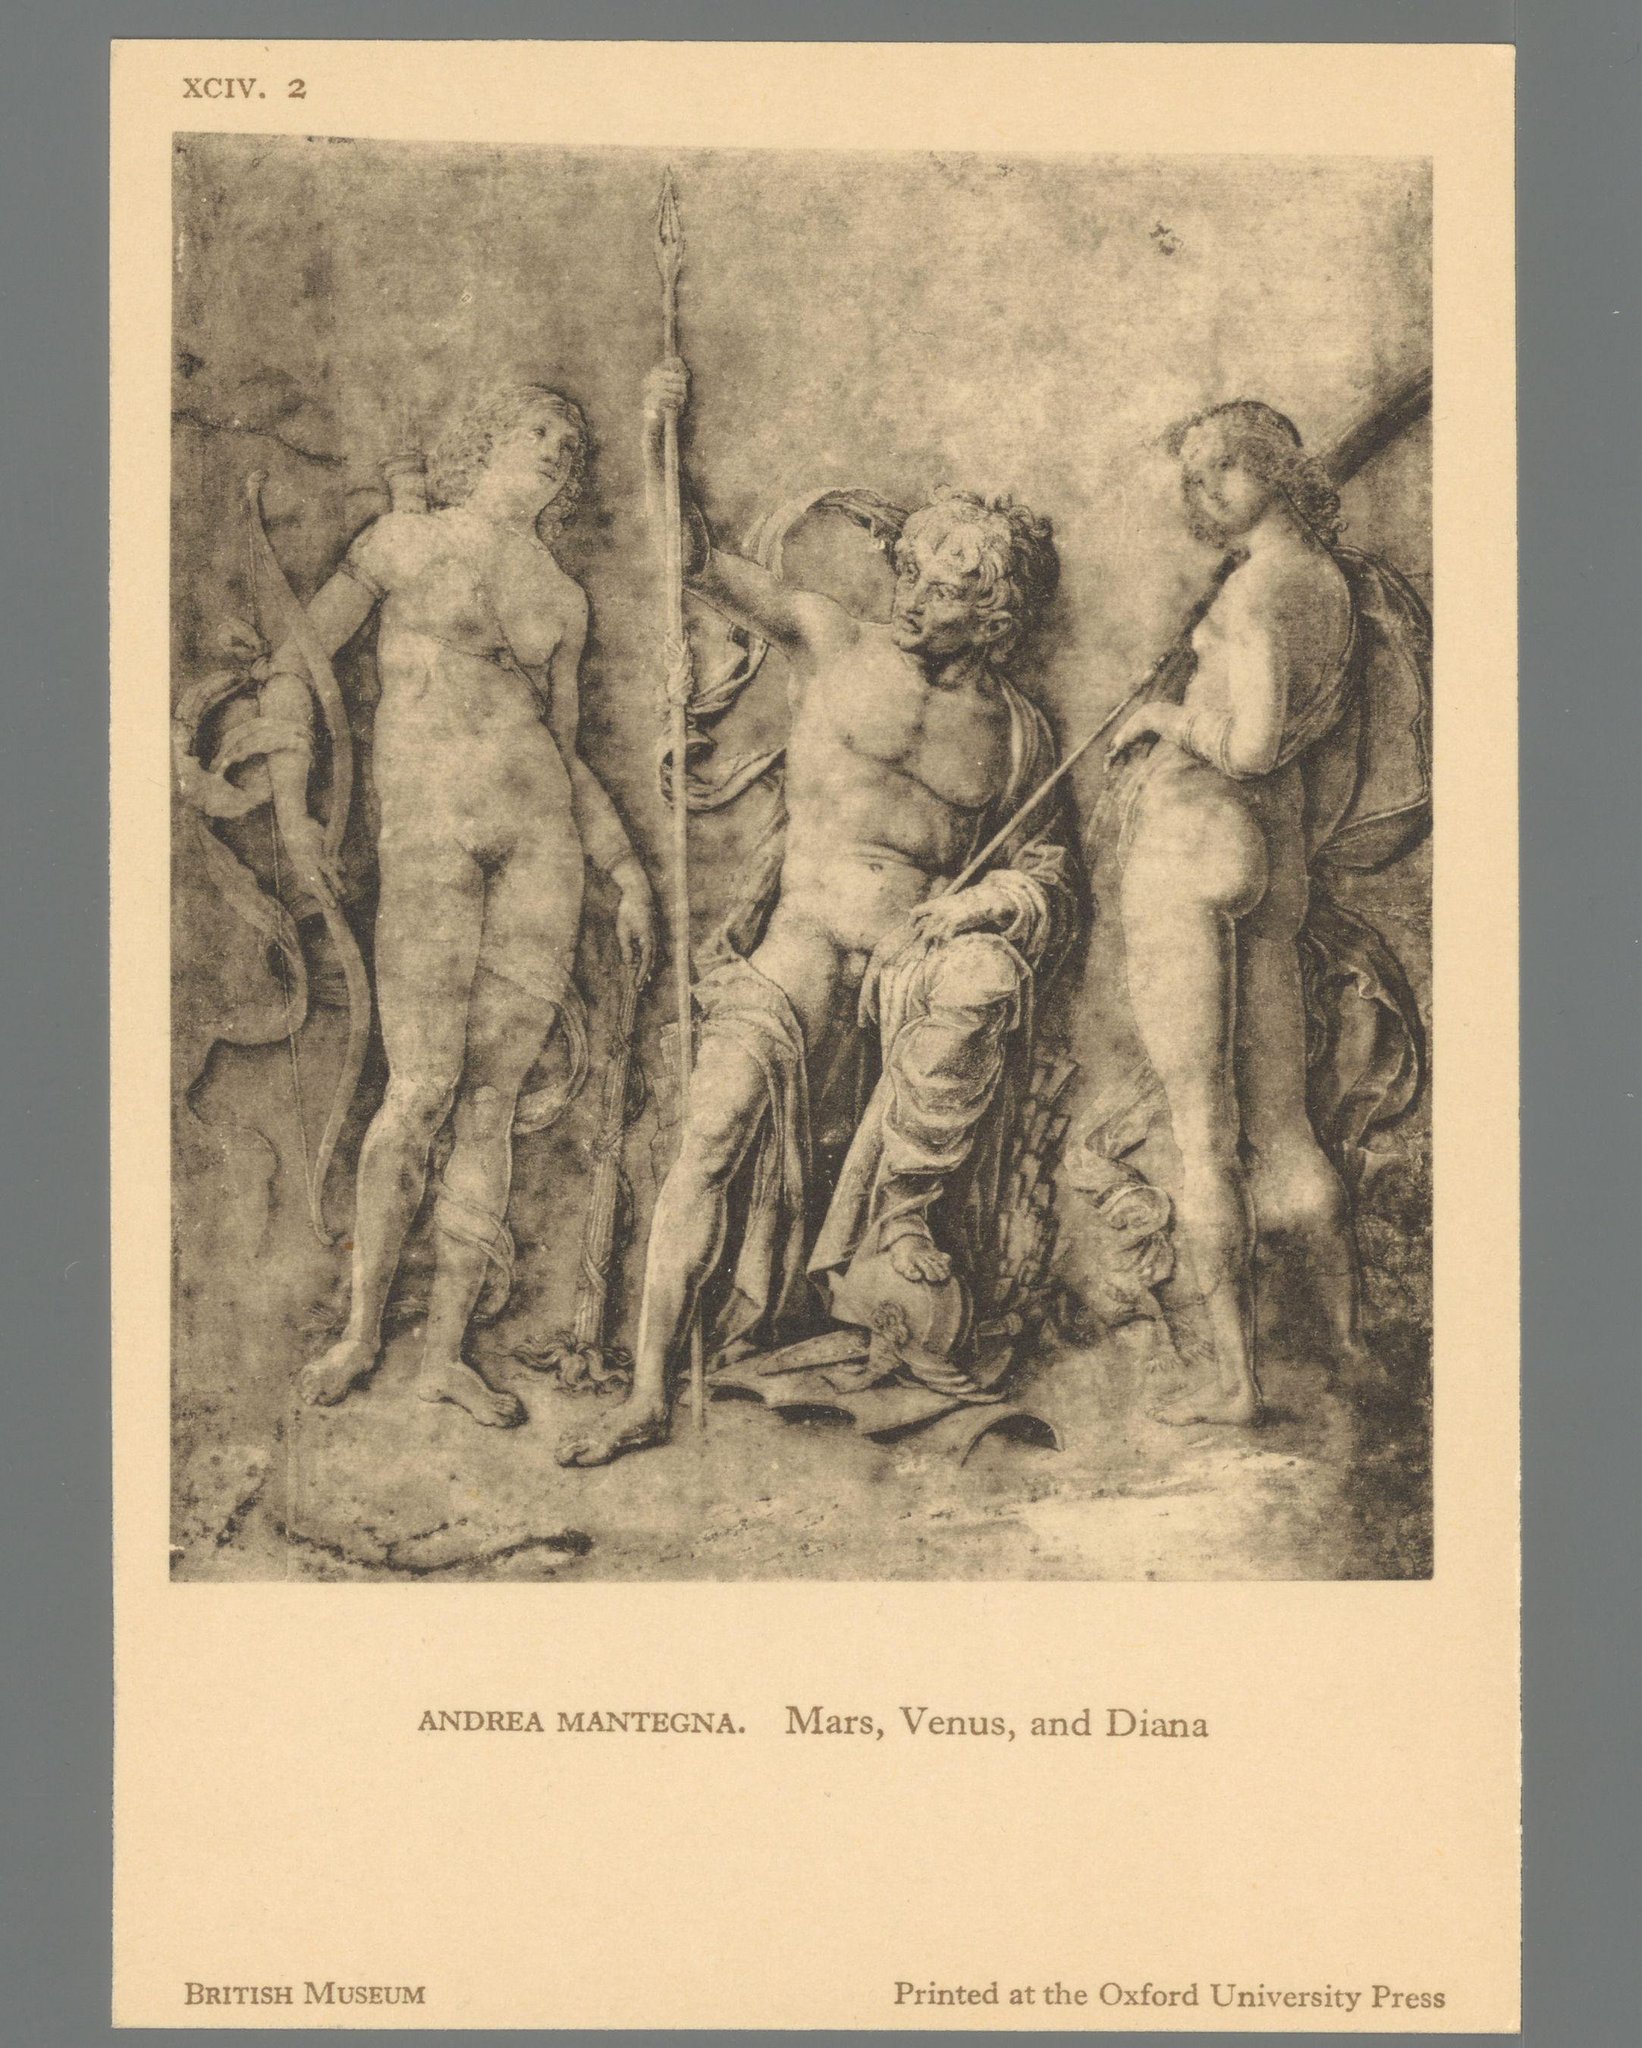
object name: ansichtkaart, prentbriefkaart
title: Andrea Mantegna. Mars, Venus, and Diana. British Museum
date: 1902-1950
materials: cardboard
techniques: photograph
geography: oxford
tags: drawing, sketch, permanent exhibition, museum